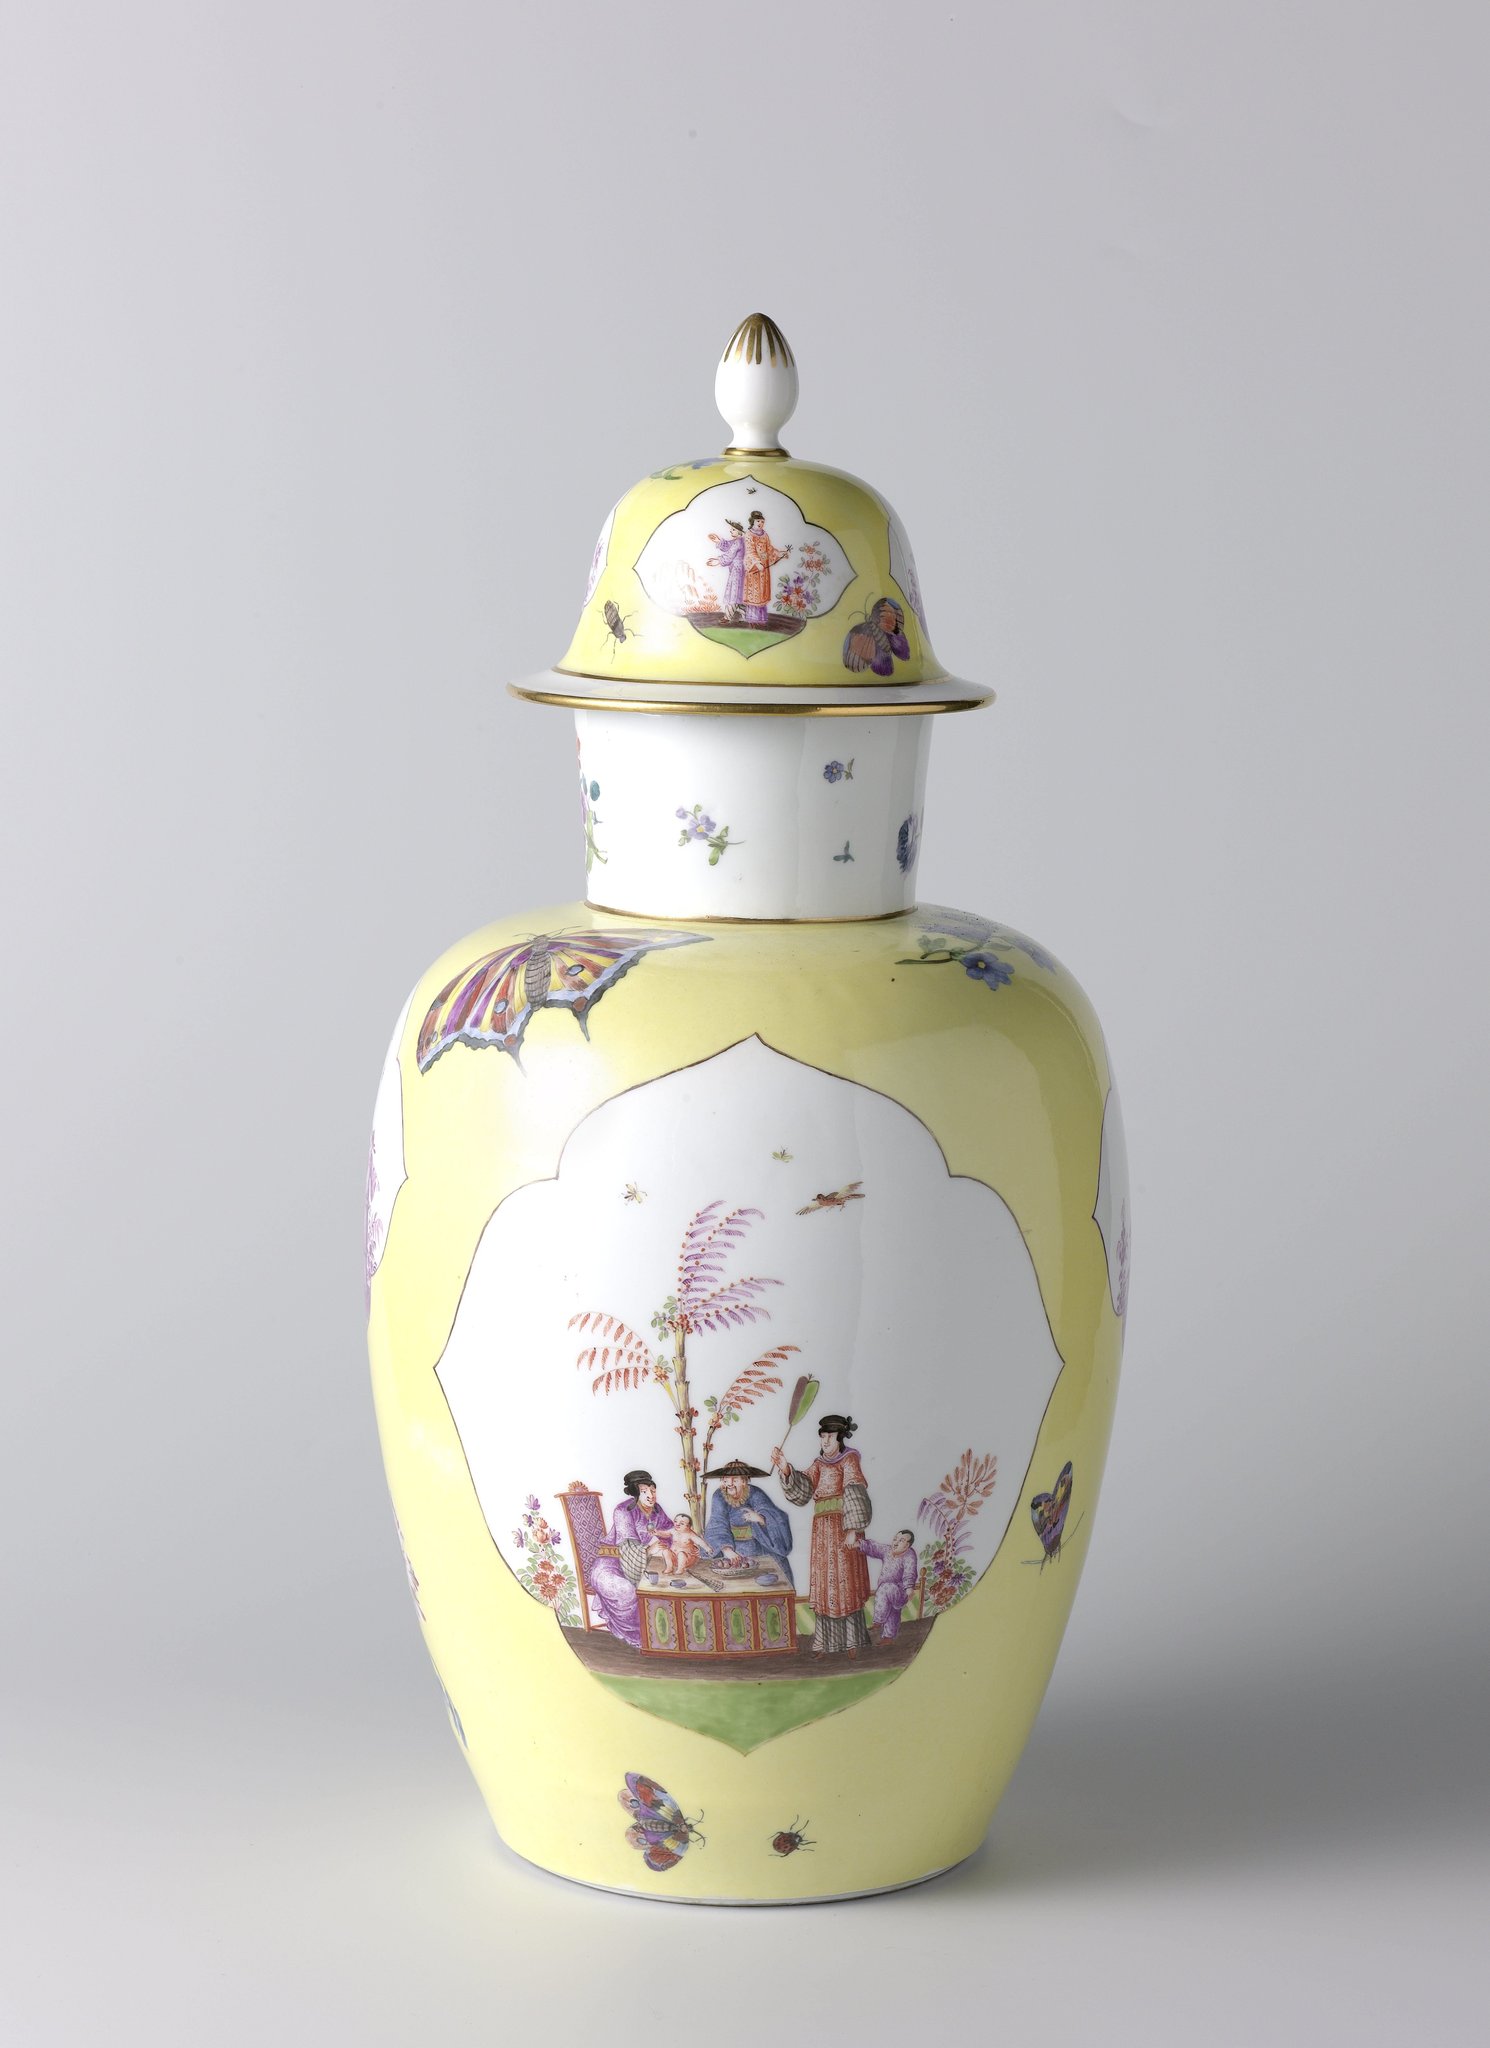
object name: lid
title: Lidded vase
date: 1740-1745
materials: porcelain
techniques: painted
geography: meissen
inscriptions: factory mark: ‘AR’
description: Op het deksel vier kleine vierpassen waarbinnen Höroldt-chinoiserieën. Tussen de uitgespaarde velden zijn bloemtakken en insekten geschilderd. Binnen een grote vierpas zijn drie figuren en een kind bij een hek geschilderd. De vaas is gemerkt.